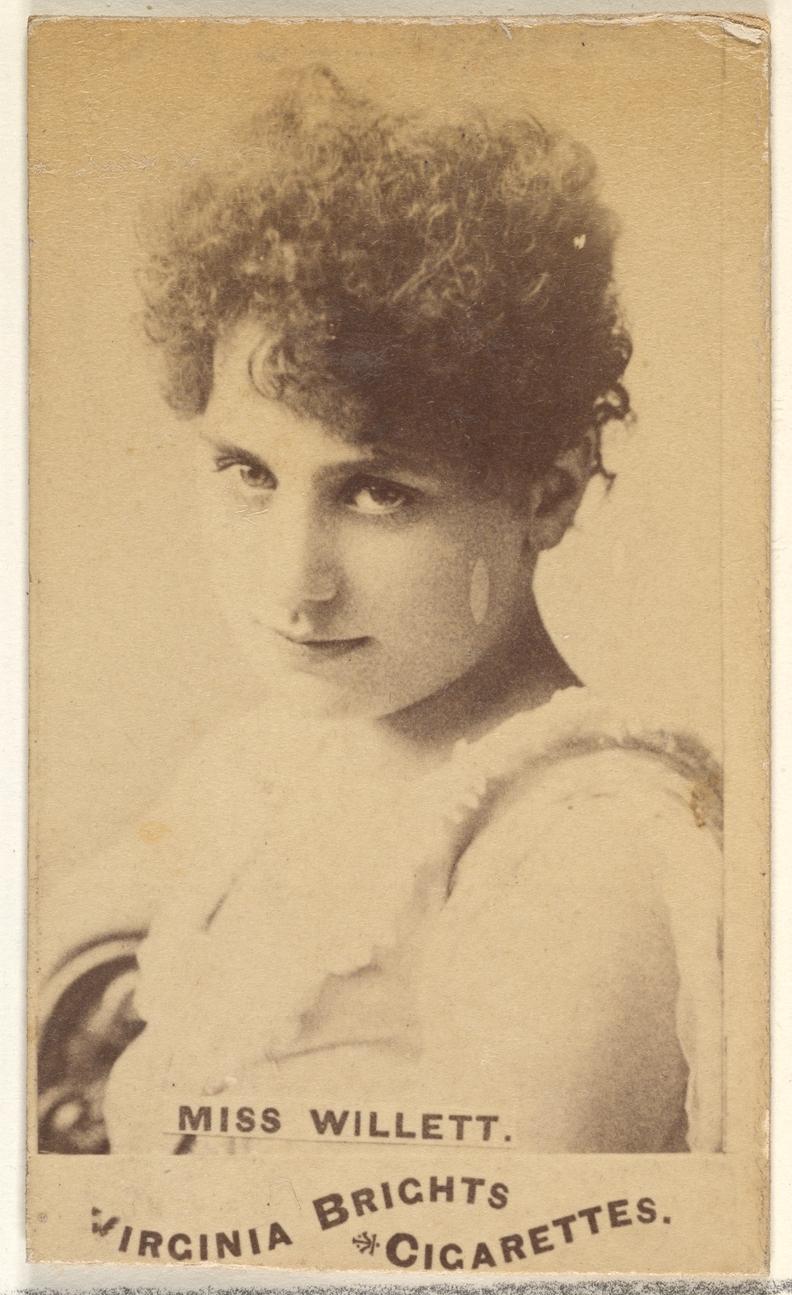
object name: photograph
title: Miss Willett, from the Actors and Actresses series (N45, Type 1) for Virginia Brights Cigarettes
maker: allen & ginter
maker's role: publisher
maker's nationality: american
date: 1888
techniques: albumen silver print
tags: portraits,women,actresses